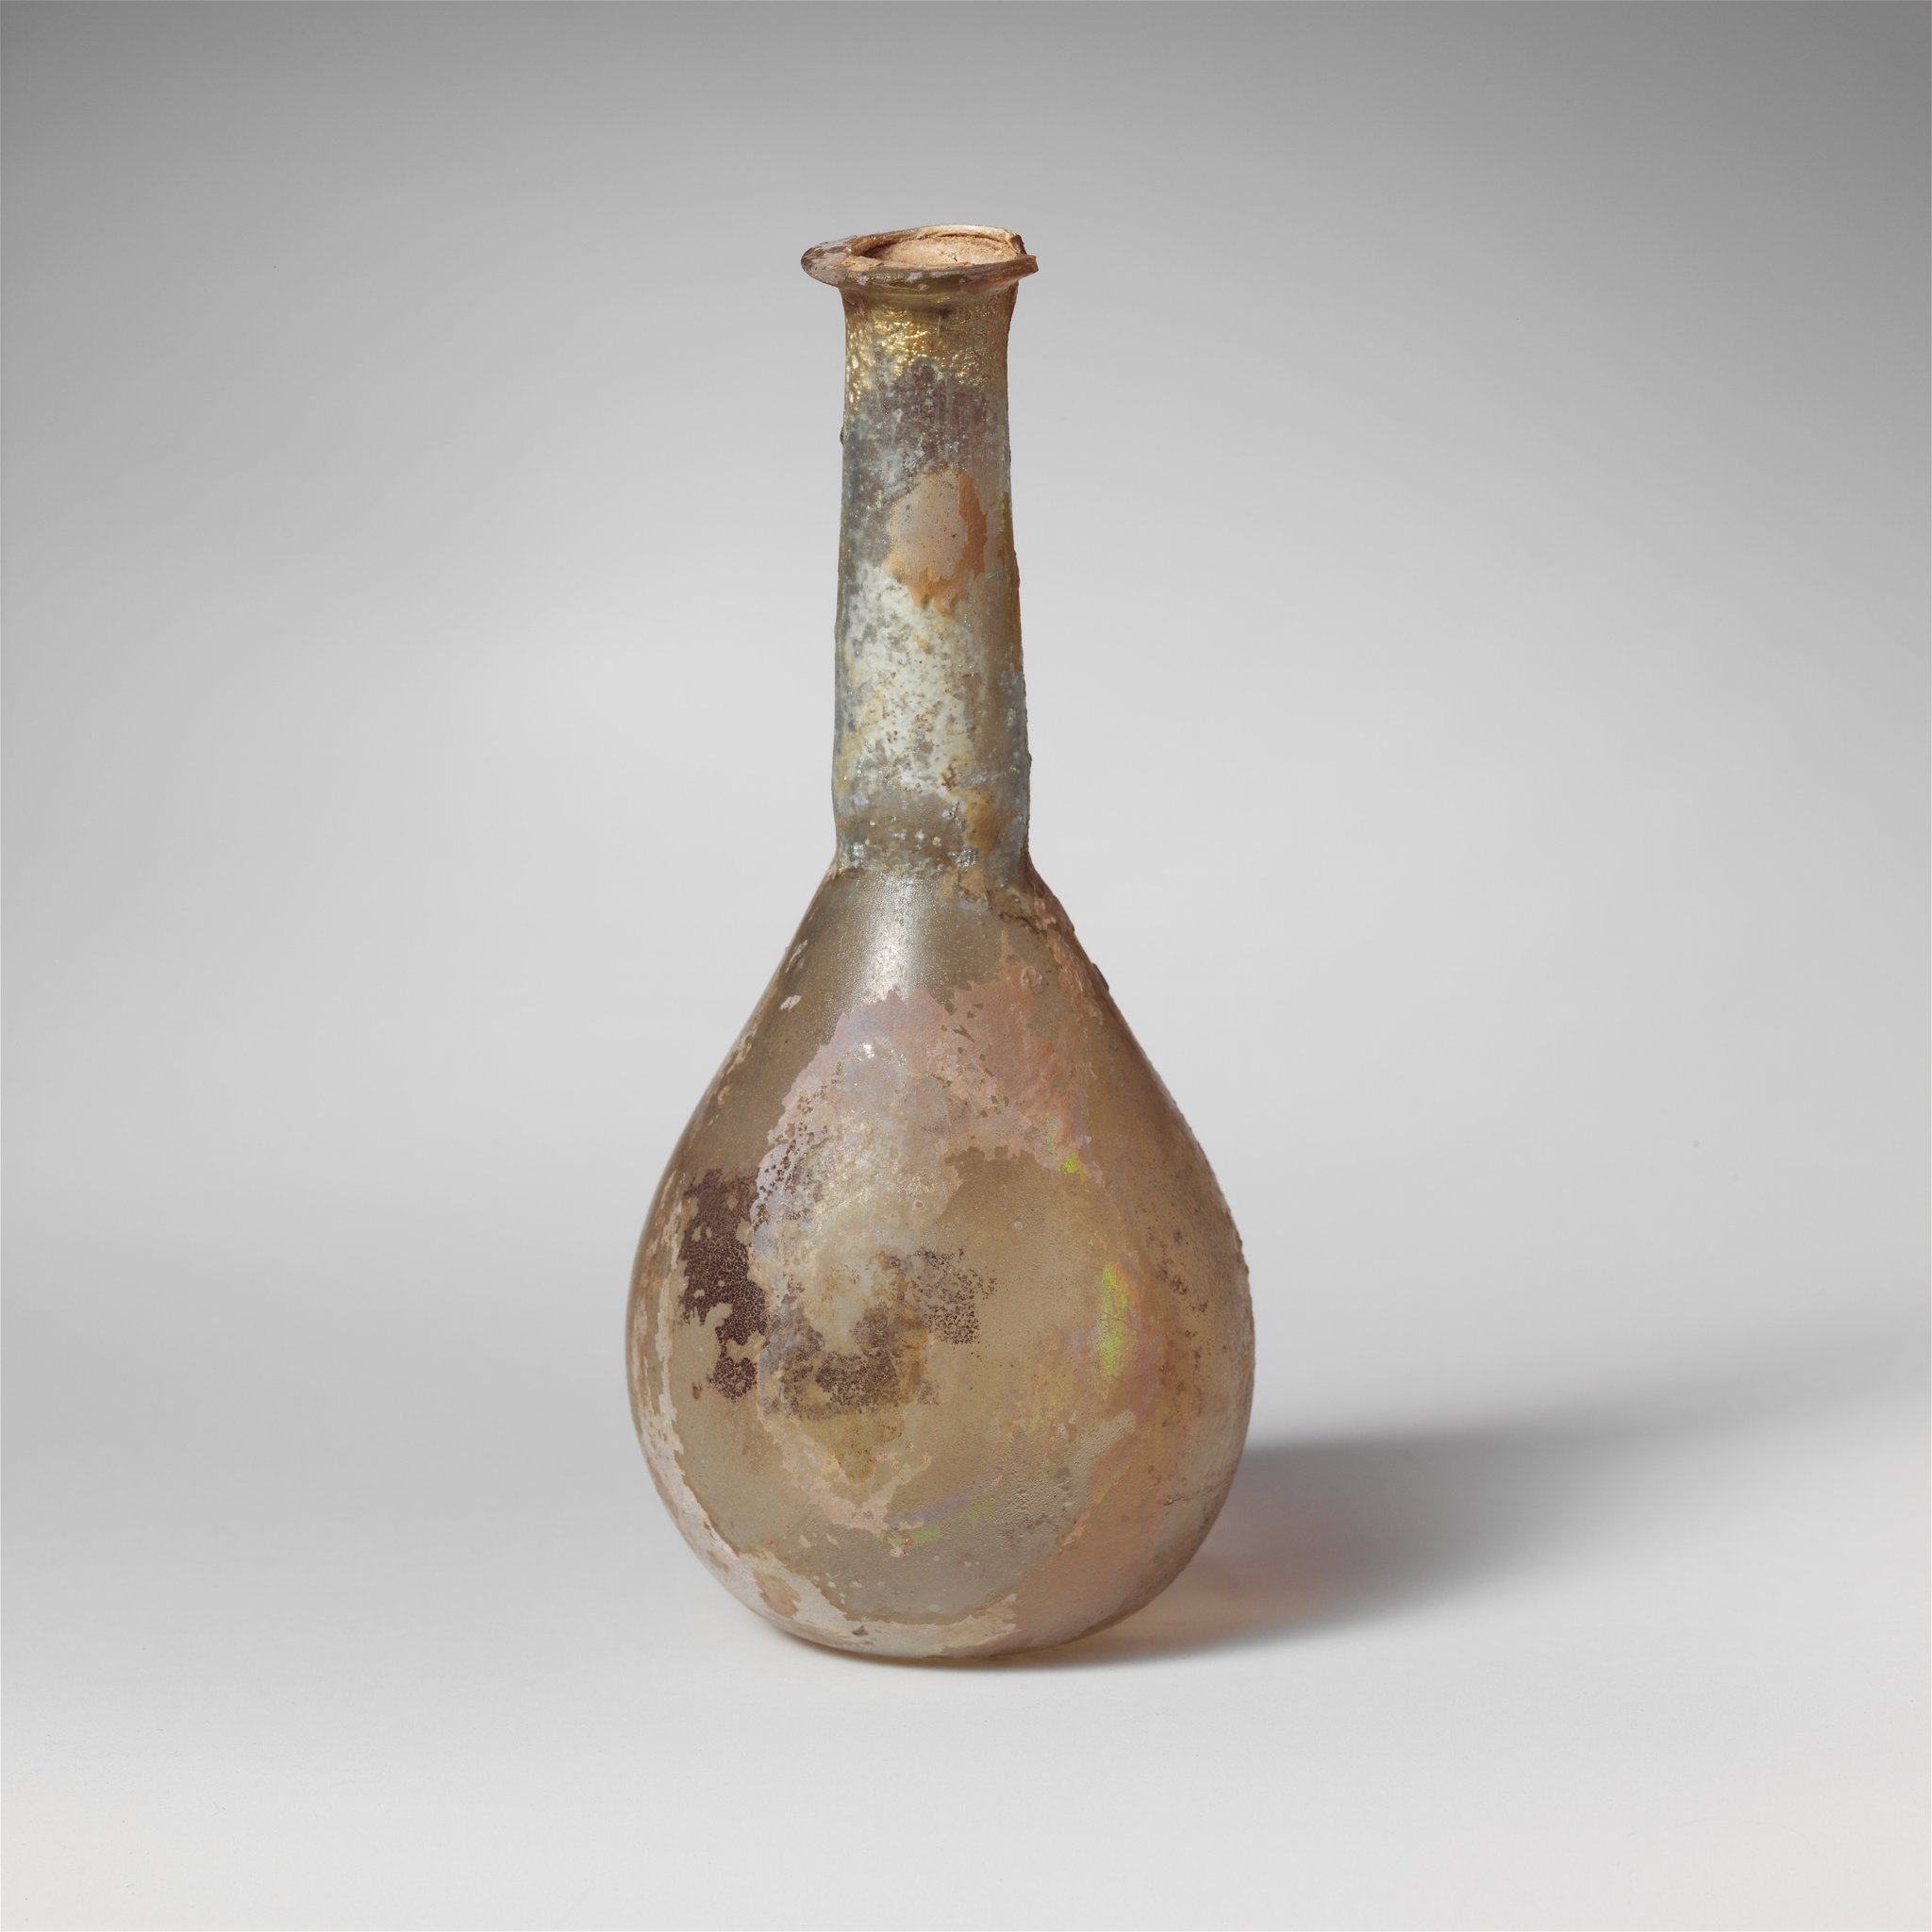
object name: perfume bottle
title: Glass perfume bottle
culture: roman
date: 1-200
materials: glass